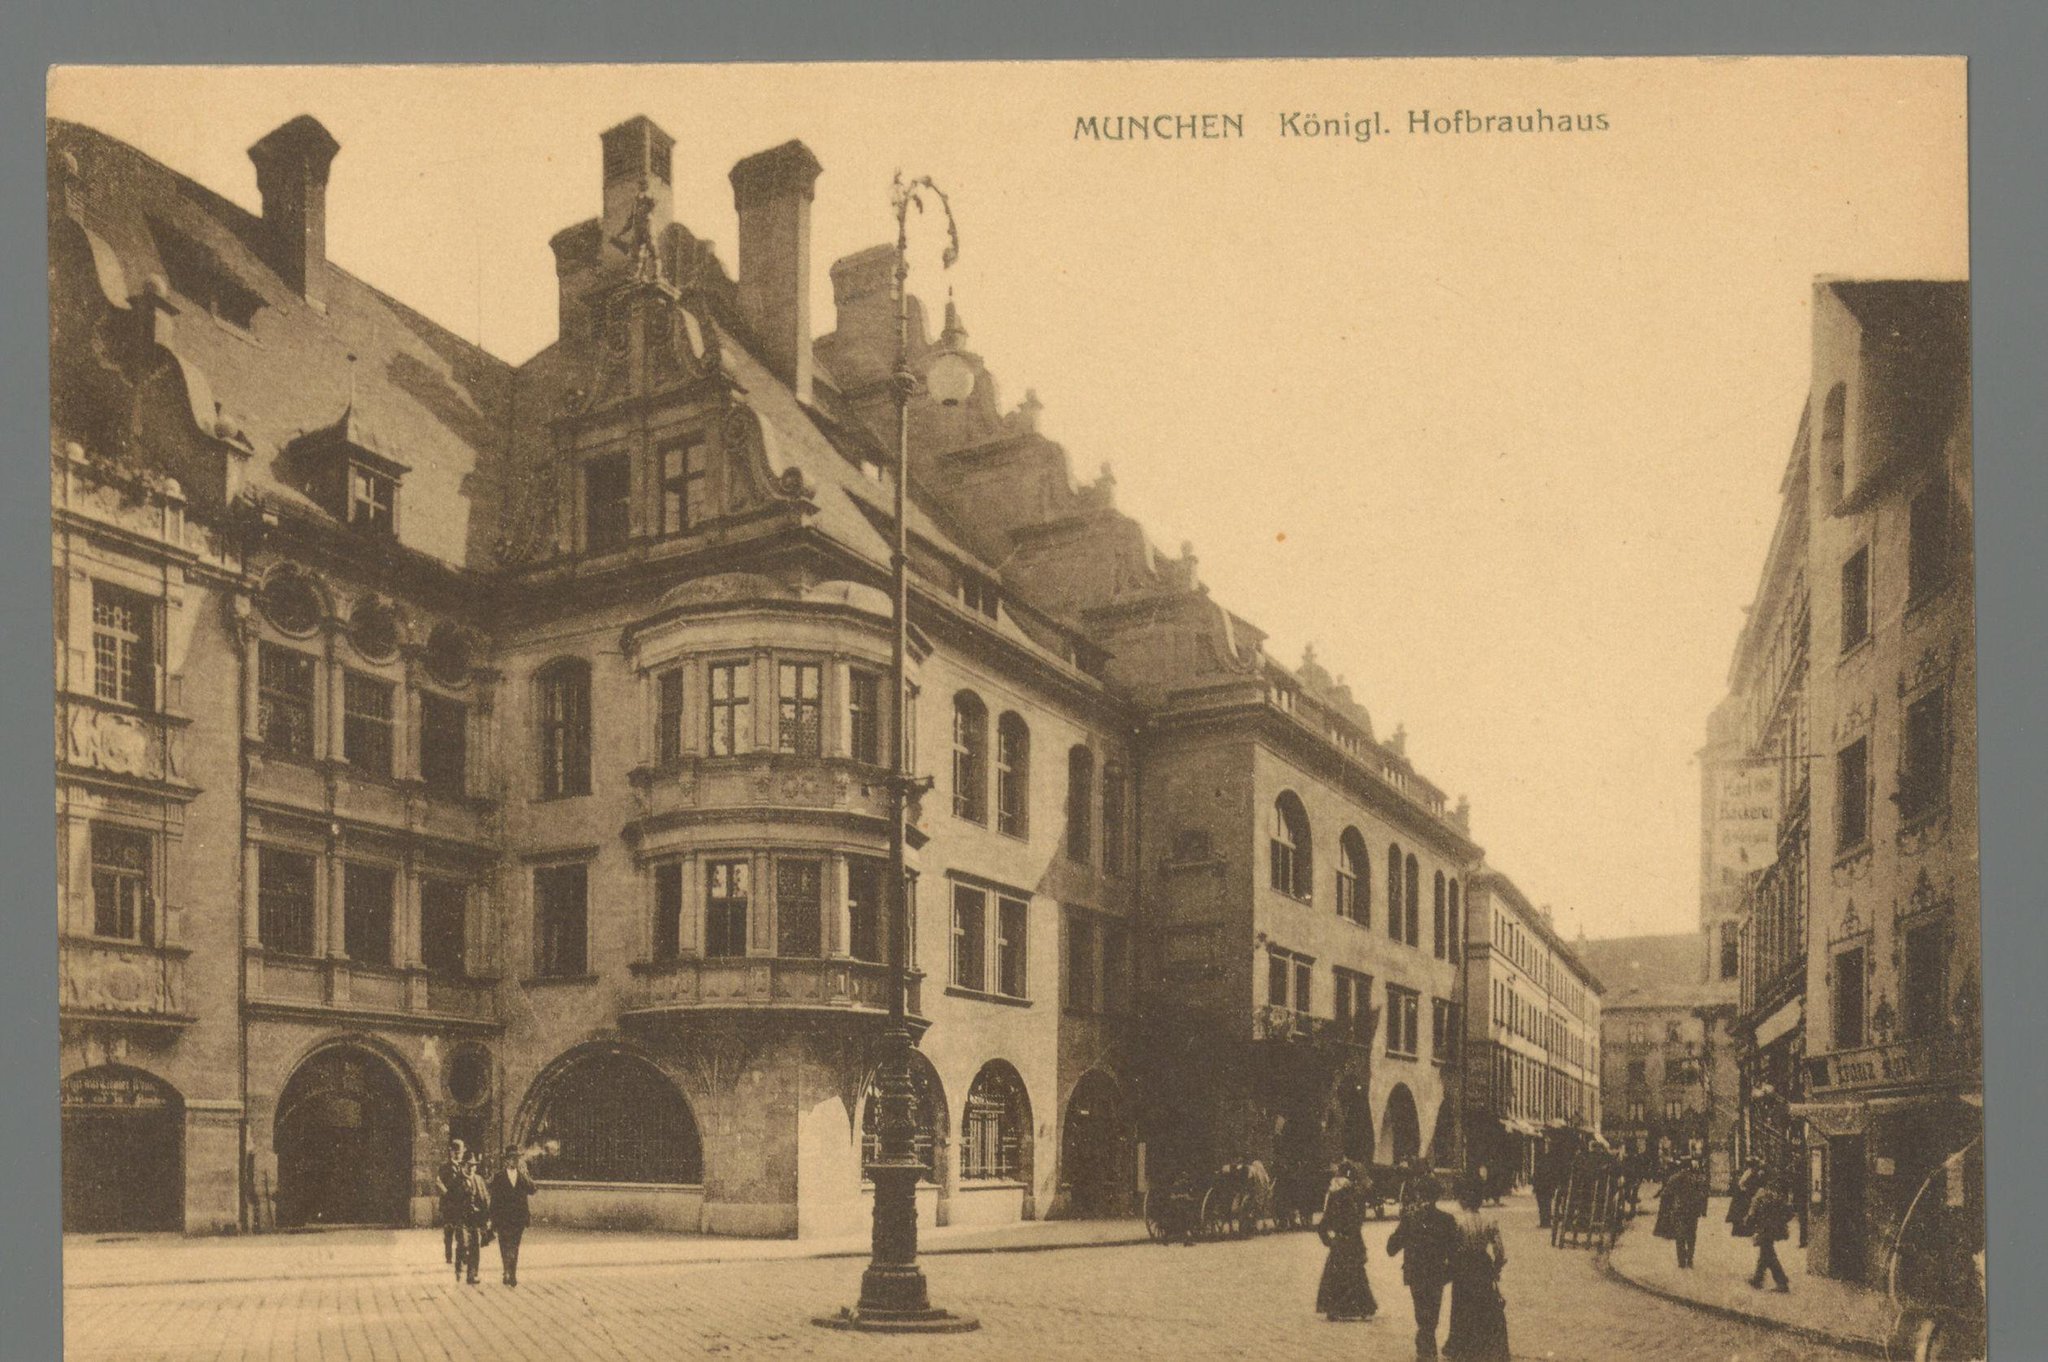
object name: photomechanical print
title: Munchen. Königl. Hofbrauhaus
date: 1905-1930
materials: cardboard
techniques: photograph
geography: munich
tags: restaurant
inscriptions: inscription: ‘W.H.D.’